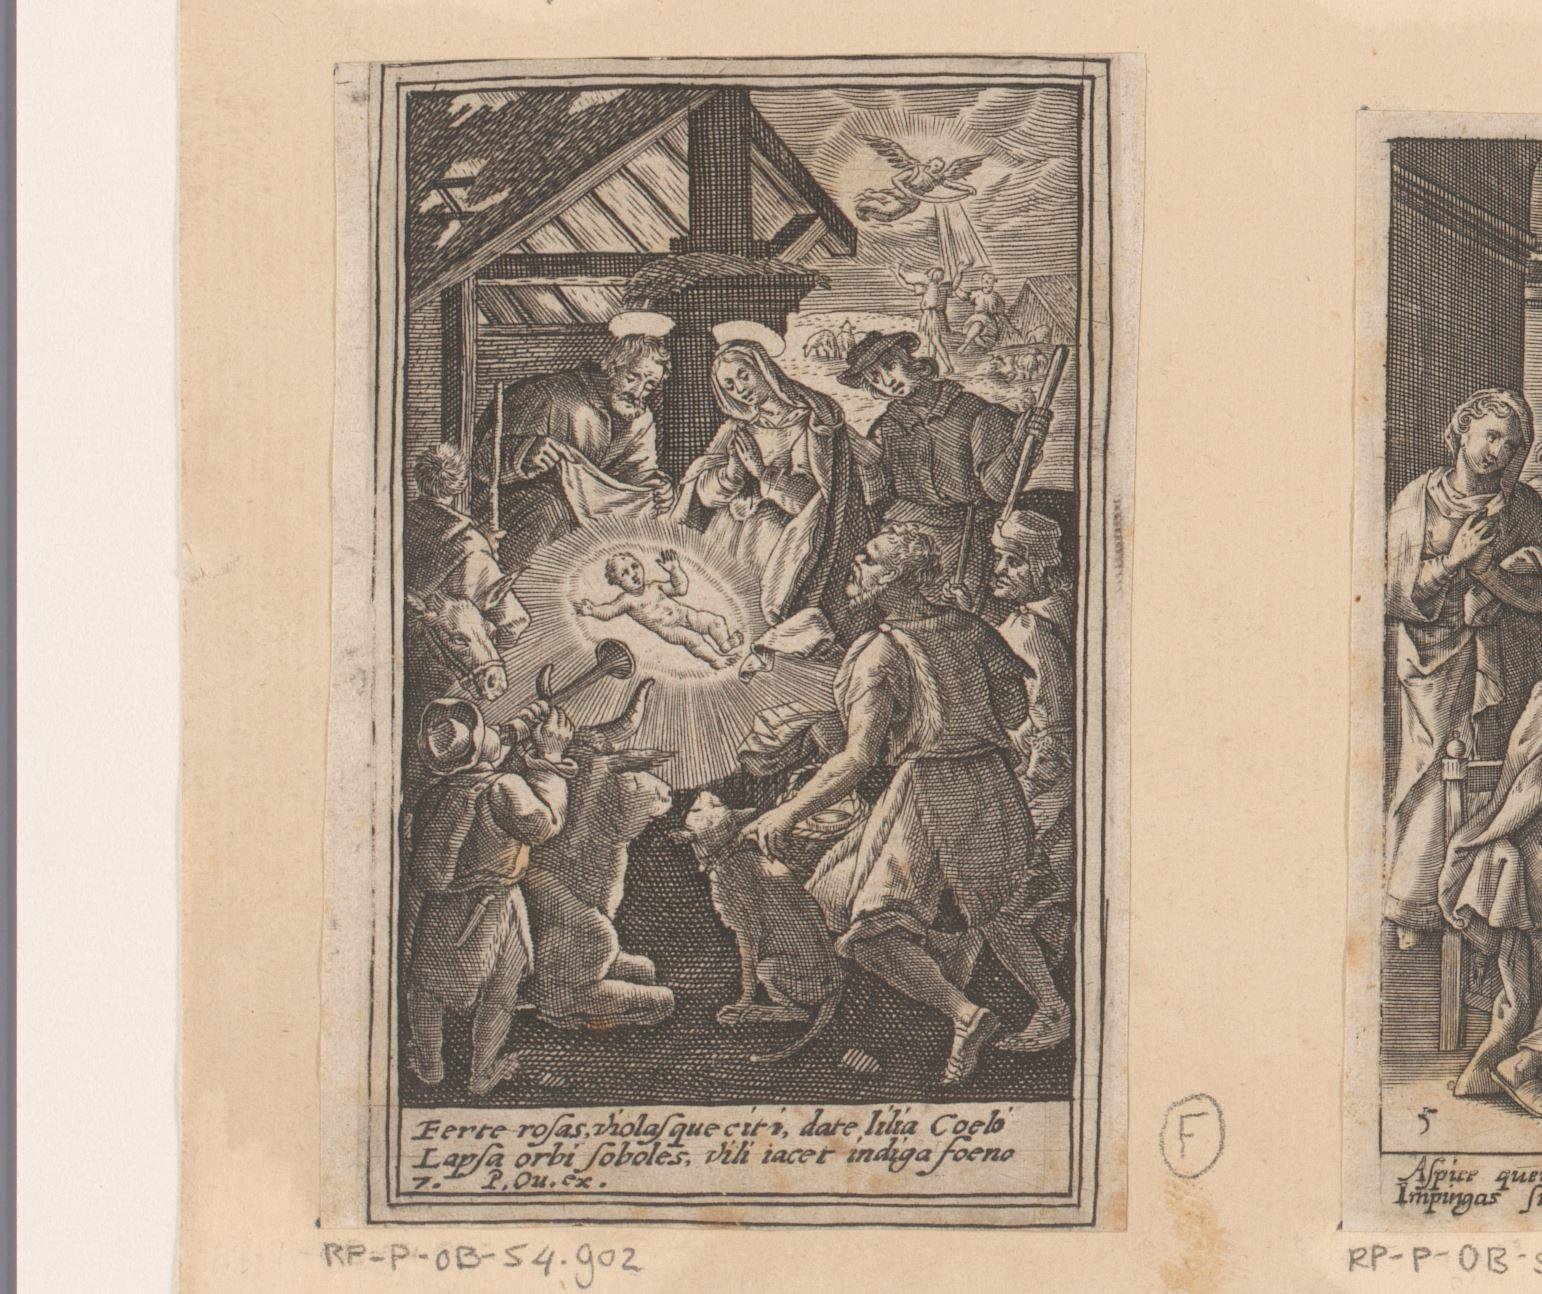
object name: print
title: Aanbidding door de herders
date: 1582-1671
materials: paper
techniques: engraving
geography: germany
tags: adoration of the christ-child by the shepherds; mary and joseph present, annunciation of christ's birth to the shepherds (and/or shepherdesses) at night; a host of singing angels in the air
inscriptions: collector's mark: Lugt 240, number: ‘38. - 64.’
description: Deze prent wordt in de collectie Rijksmuseum bewaard bij de serie 'Vita, passio et resurrectio Jesu Christi' (Leven, passie en wederopstanding van Christus) door Heinrich Ulrich. Echter wijkt de nummering en vorm van deze prent af van de rest van de serie.